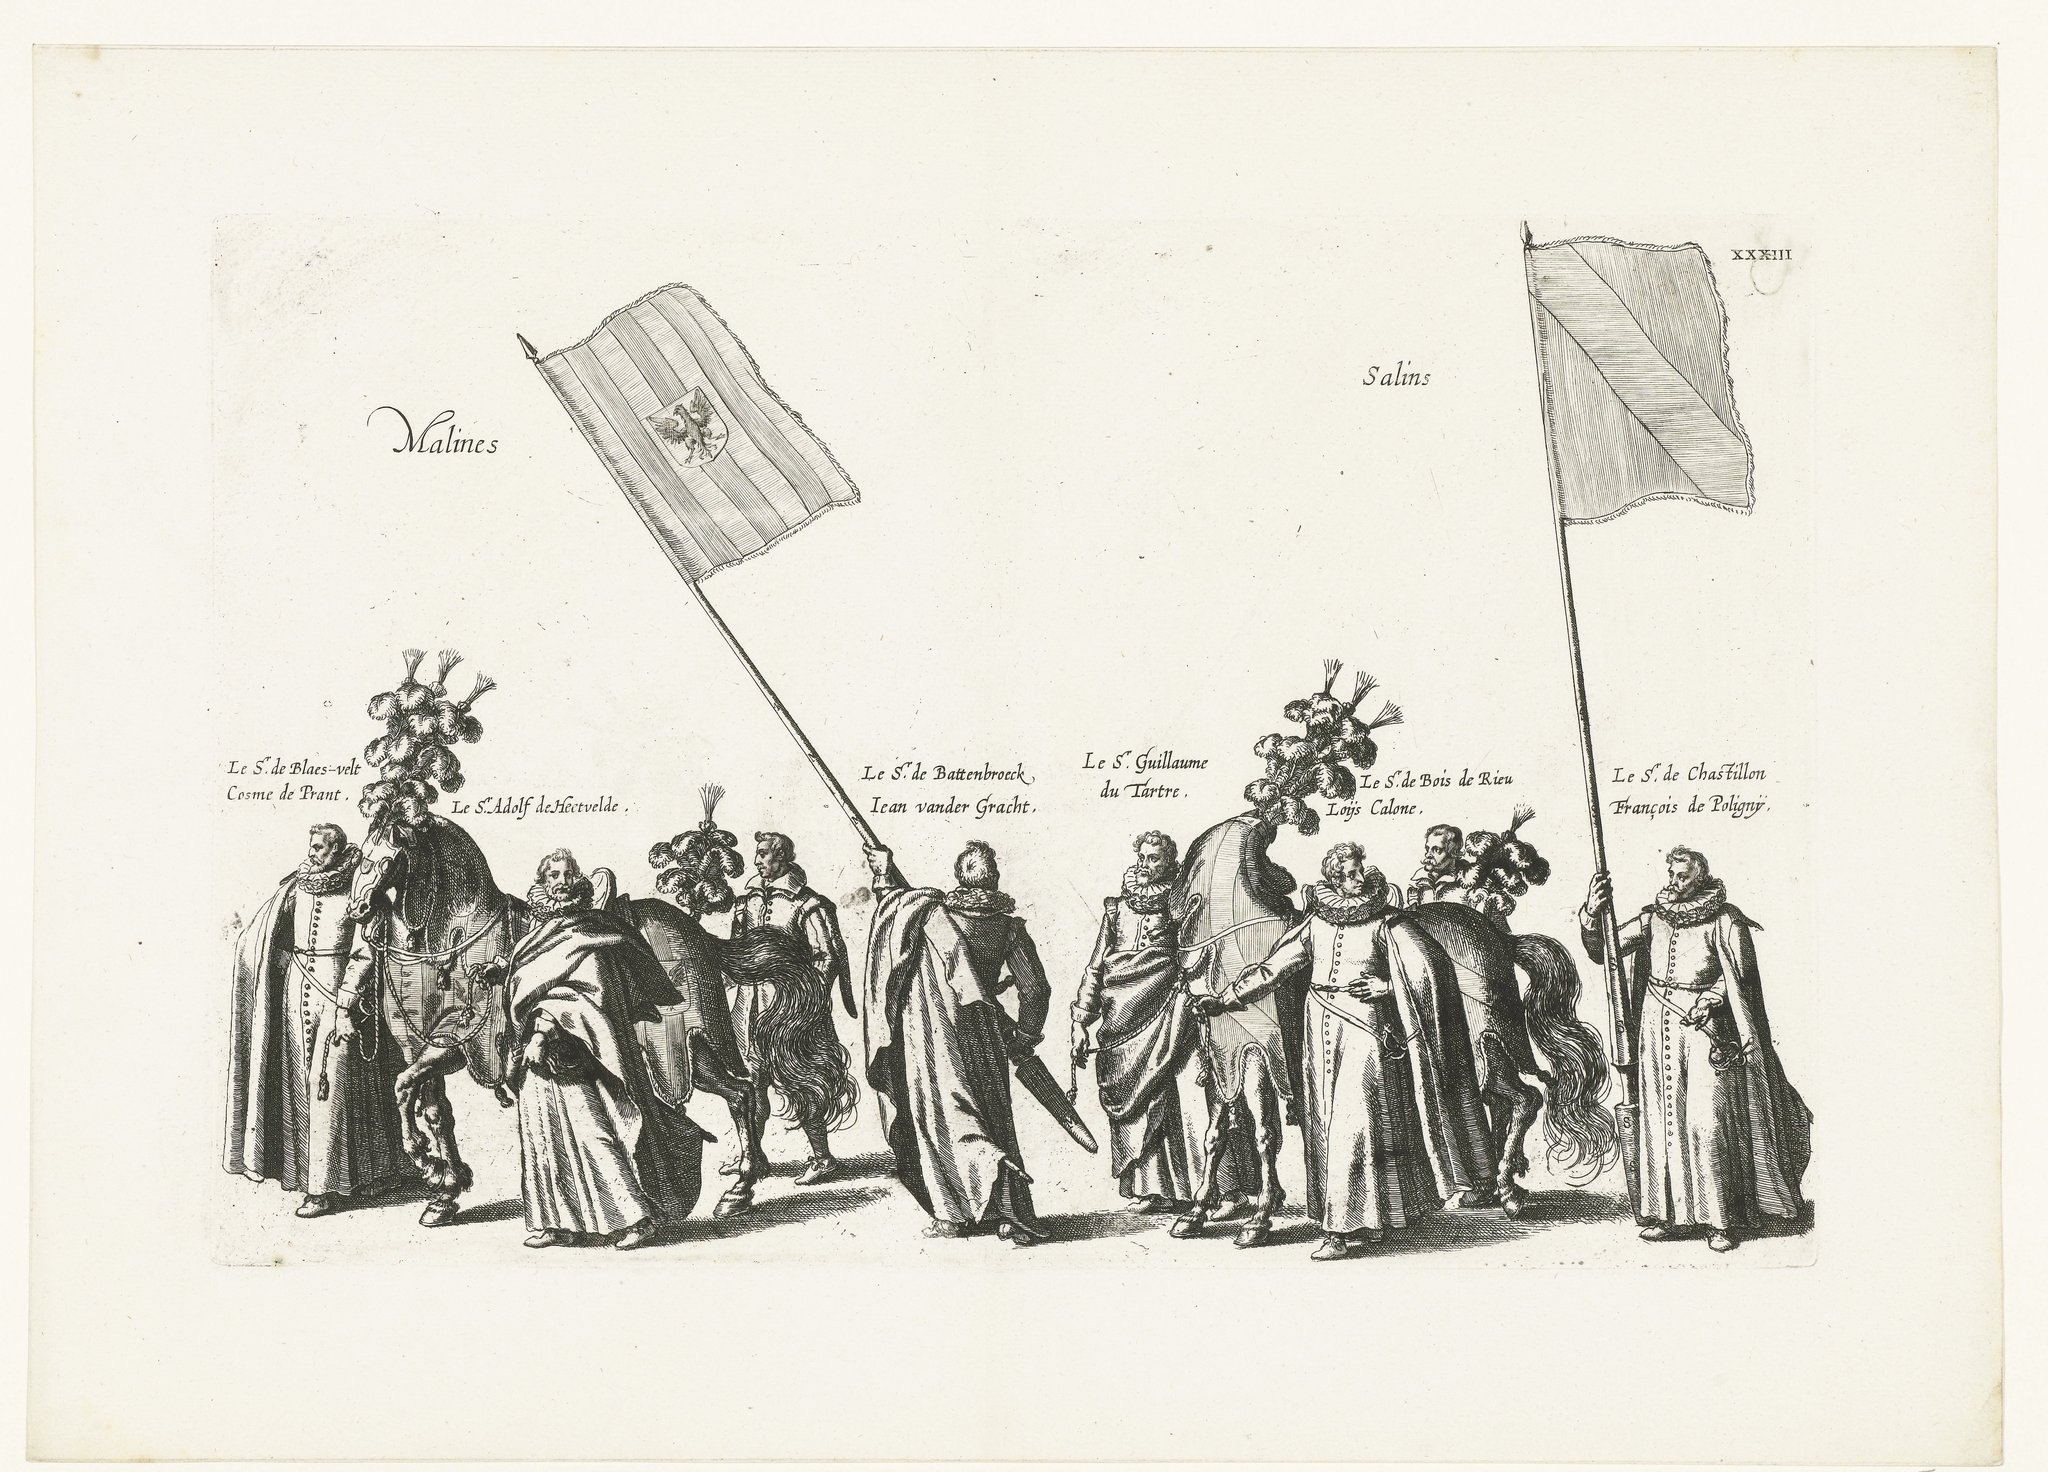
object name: print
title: Begrafenis van aartshertog Albrecht, 1622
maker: cornelis galle (i)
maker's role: print maker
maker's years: 1576-1650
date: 1623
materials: paper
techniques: etching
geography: southern netherlands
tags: brussels, albrecht aartshertog van oostenrijk, cortege, funeral procession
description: Deelnemers in de begrafenisstoet met vaandels van Mechelen en Salins-les-Bains. Plaat XXXIII in de serie van de begrafenis van aartshertog Albrecht van Oostenrijk te Brussel op 12 maart 1622.